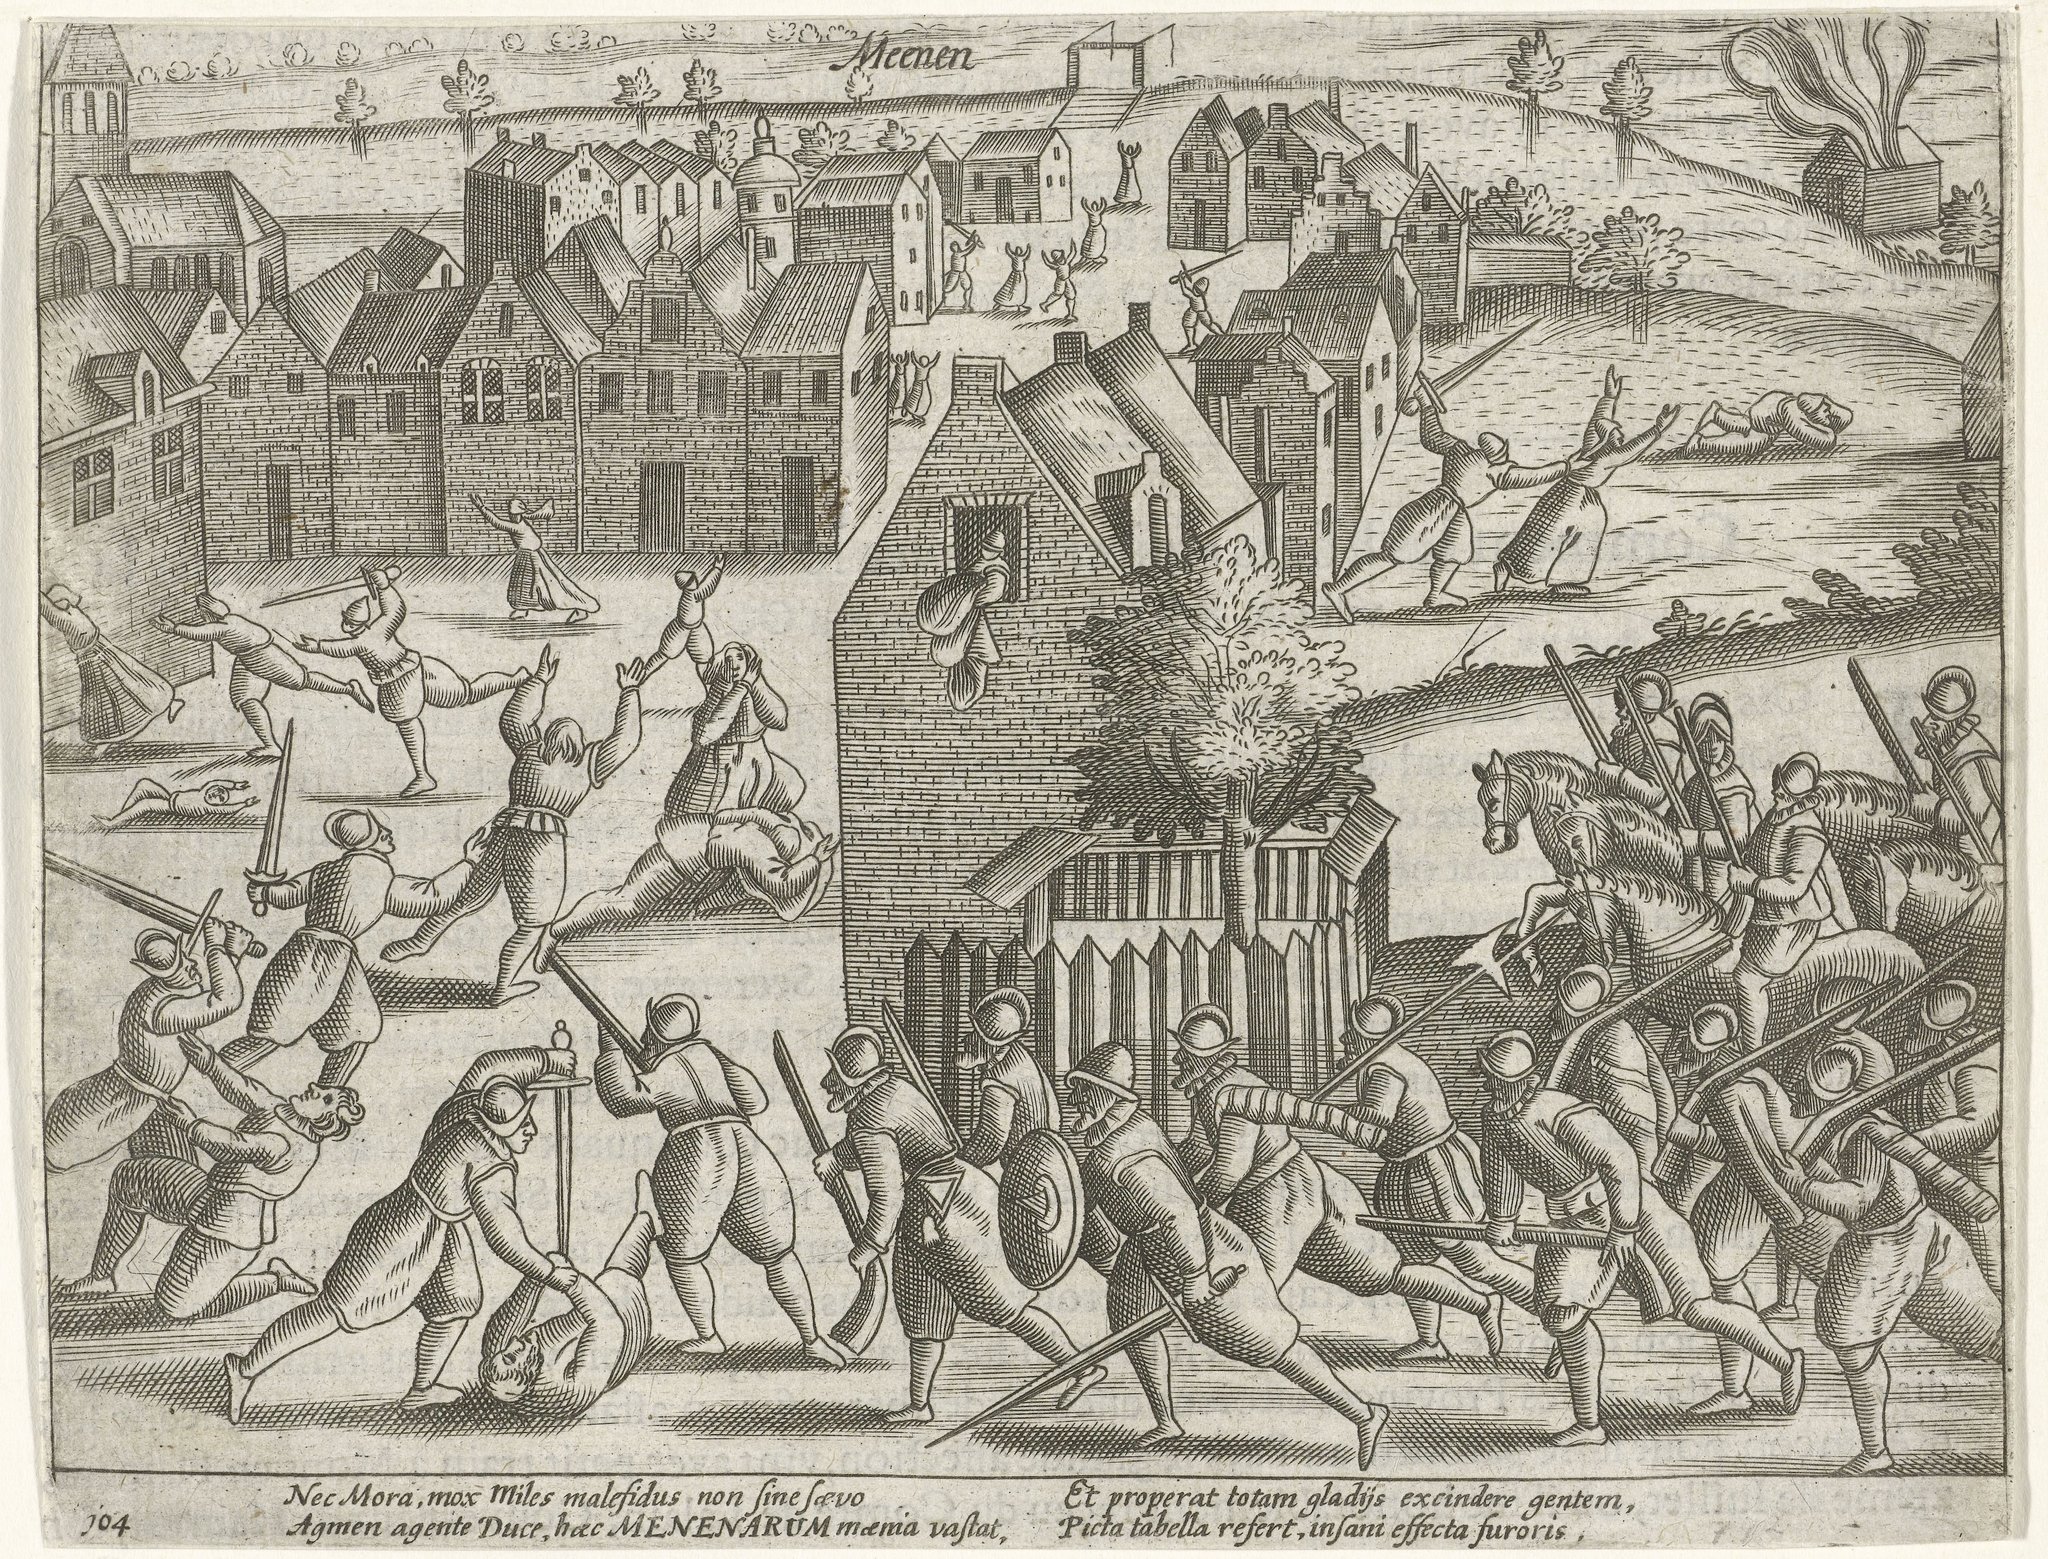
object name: print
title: Menen veroverd door de Malcontenten, 1578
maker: Anonymous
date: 1613-1615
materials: paper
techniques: engraving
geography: northern netherlands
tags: capture of city (after the siege)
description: Het stadje Menen veroverd door de Malcontenten, 24 september 1578. Gezicht in de straten waar gevochten wordt. Met onderschrift van 4 regels in het Latijn. Genummerd: 104. Bedrukt op achterzijde met tekst in het Frans.